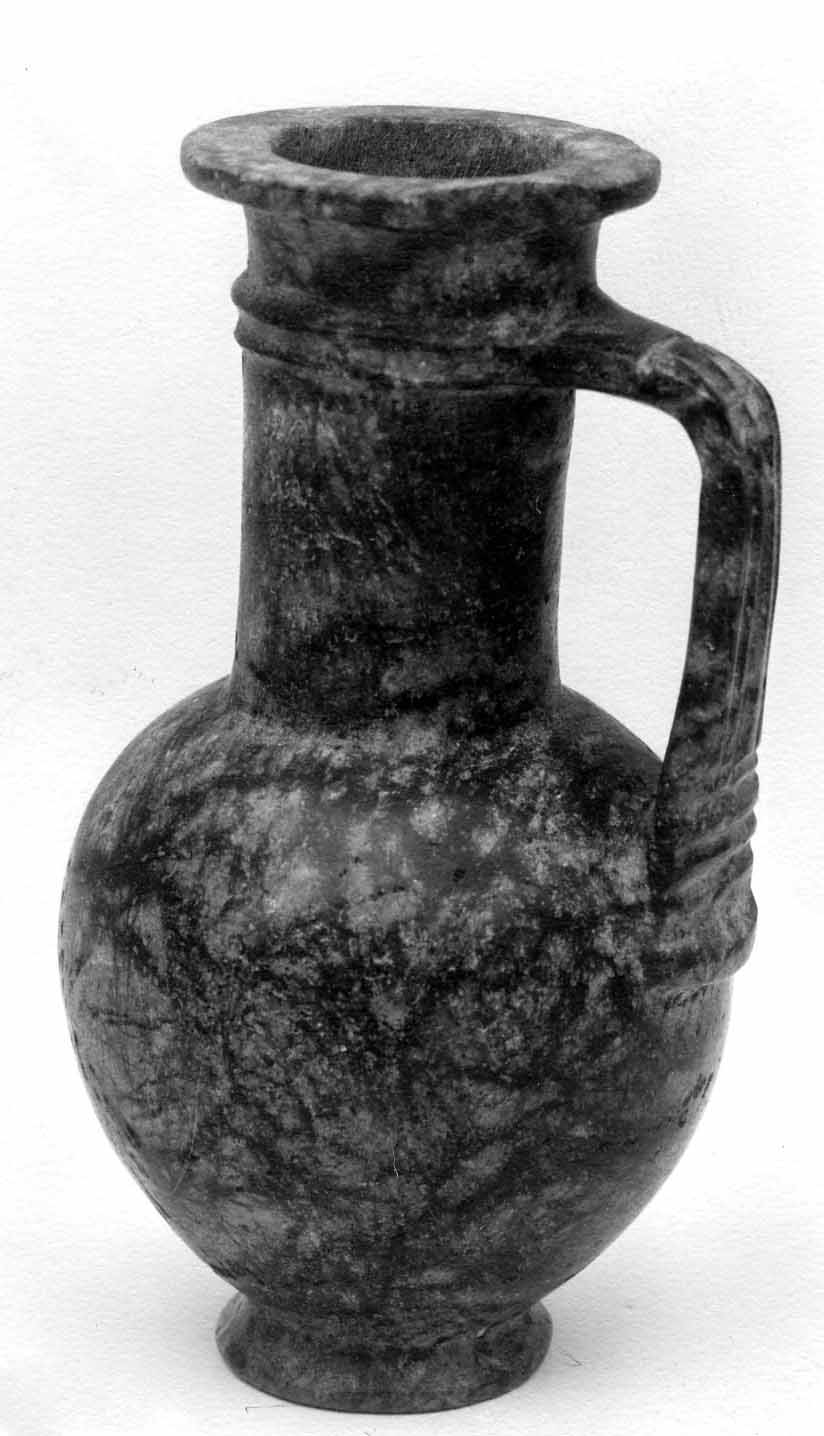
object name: jug, ring base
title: Jug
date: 1550-1295 BCE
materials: stone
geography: egypt